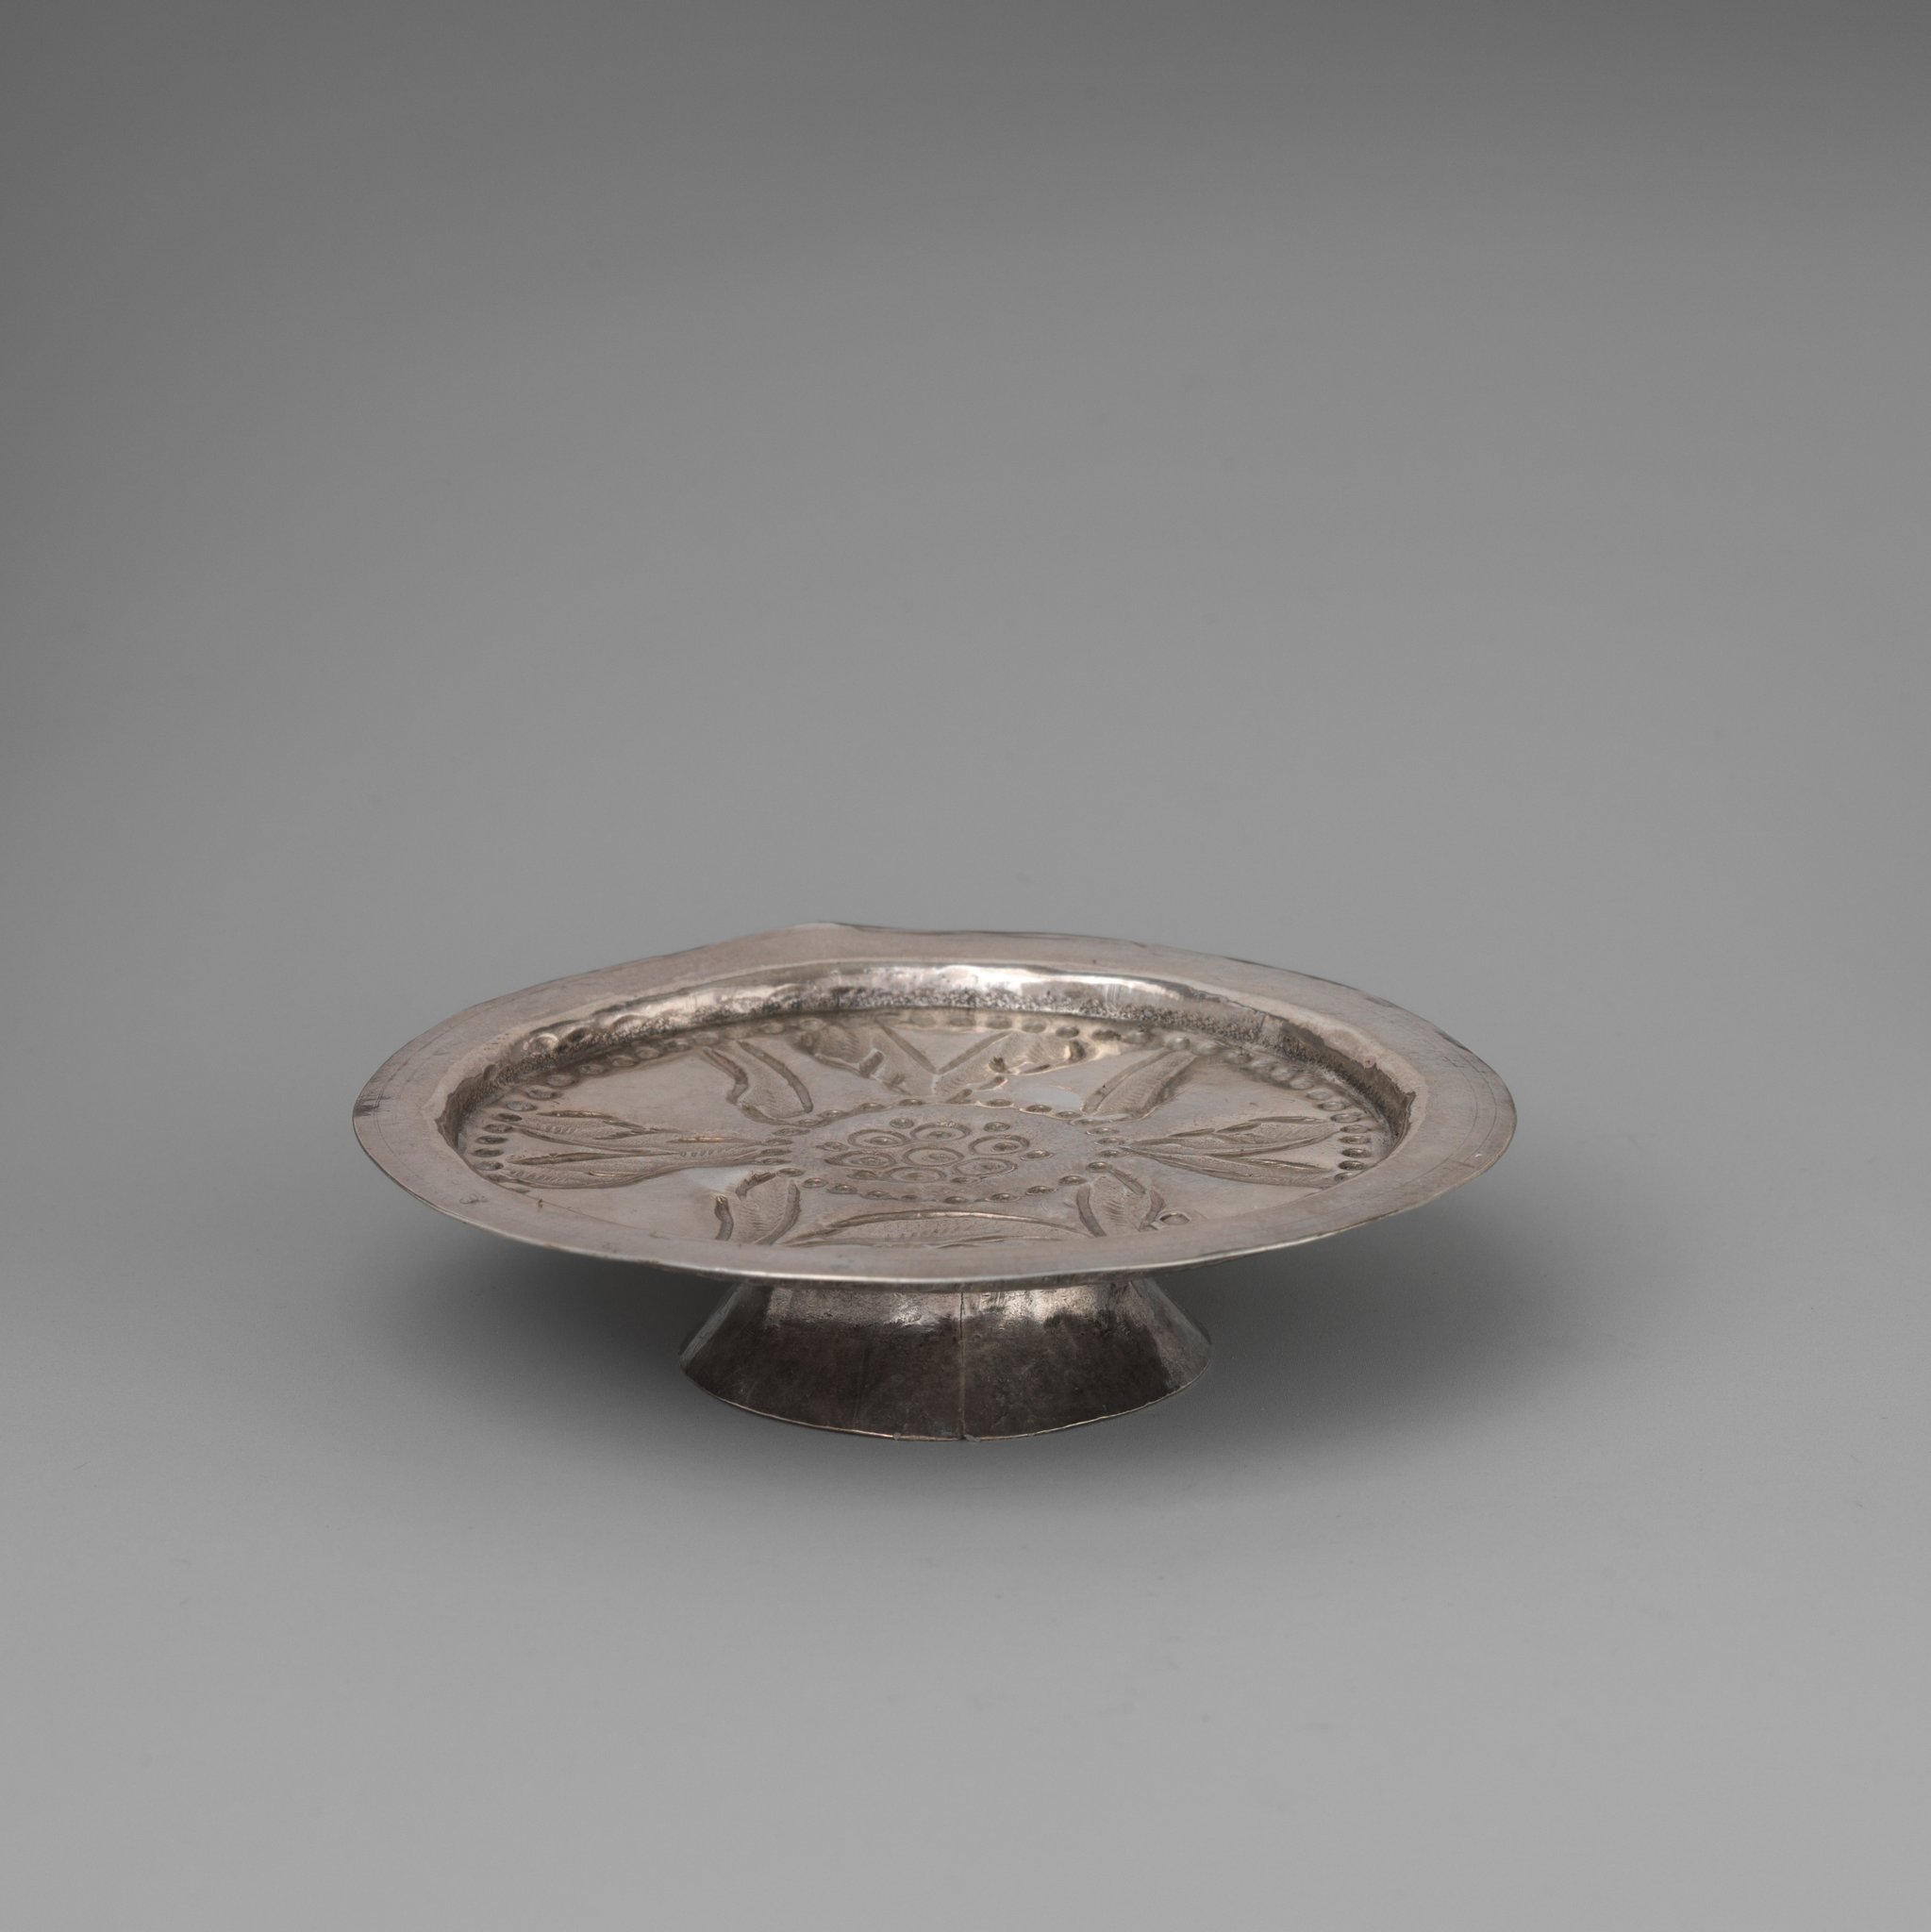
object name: stand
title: Miniature stand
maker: george manjoy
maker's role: maker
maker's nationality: british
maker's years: 1685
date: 1691-1692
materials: silver